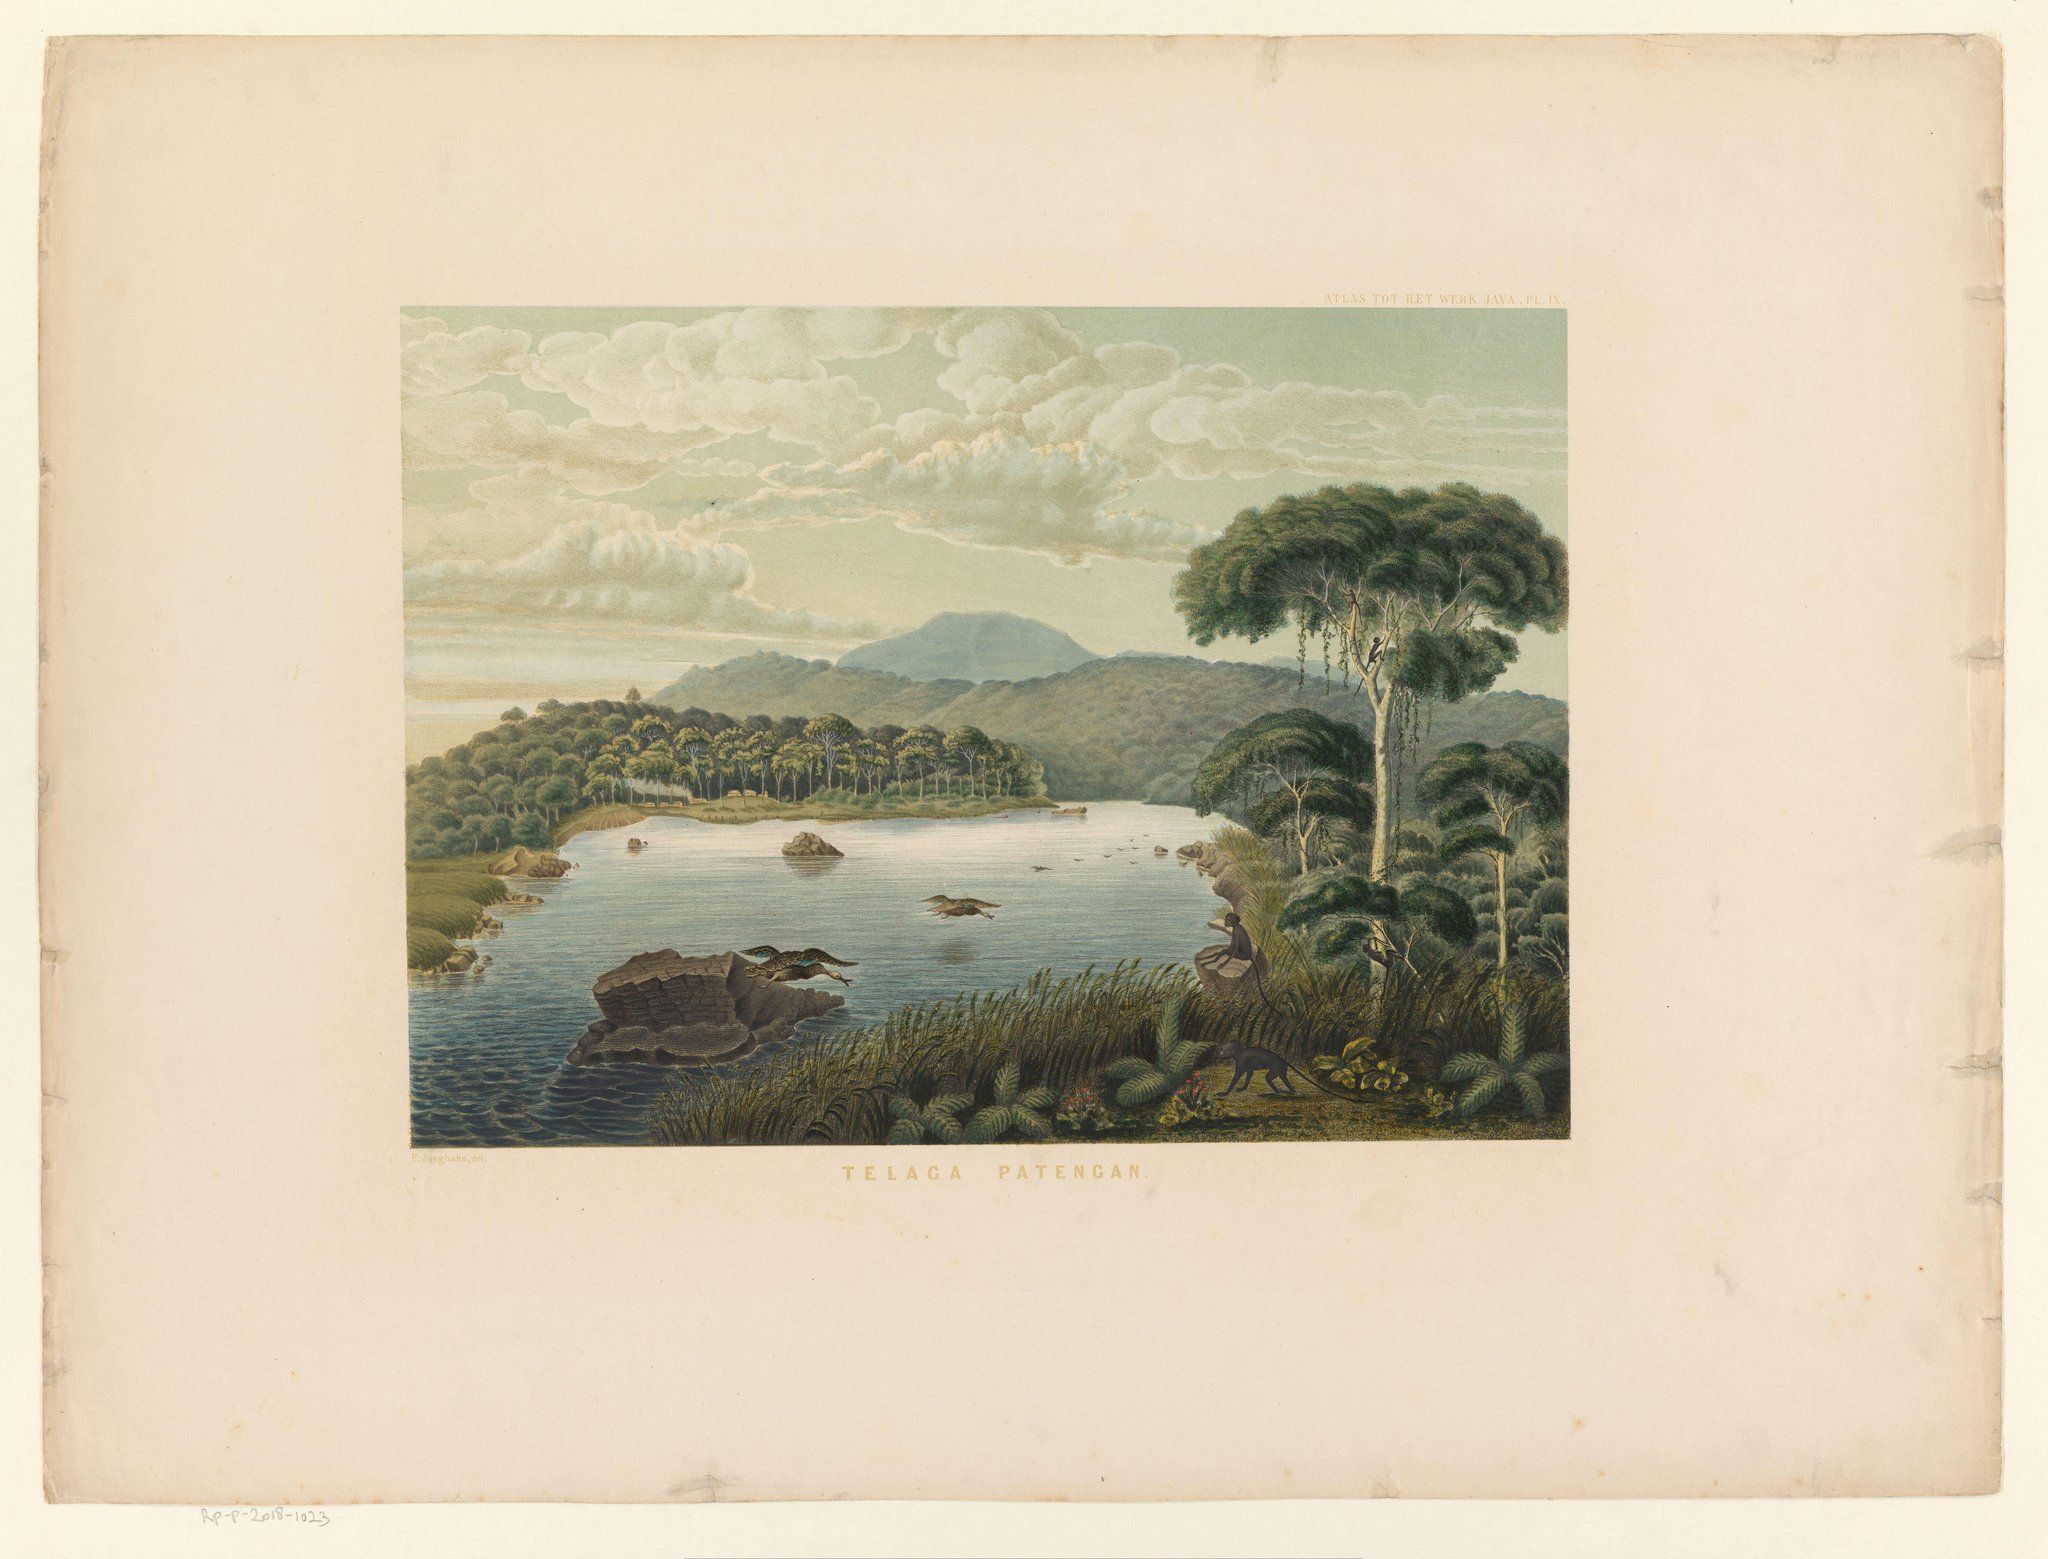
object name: print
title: Telaga Patengan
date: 1854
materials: paper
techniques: lithograph, hand coloring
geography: the hague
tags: landscapes in the non-temperate zone, exotic landscapes, lake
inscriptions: collector's mark: Lugt 2228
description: Onderdeel van een serie van elf, bedoeld als aanvulling op: Junghuhn, Franz. Java: zijne gedaante, zijn plantentooi en inwendige bouw. 4 dln. Den Haag: Carl Wilheml Mieling, 1853-1854.